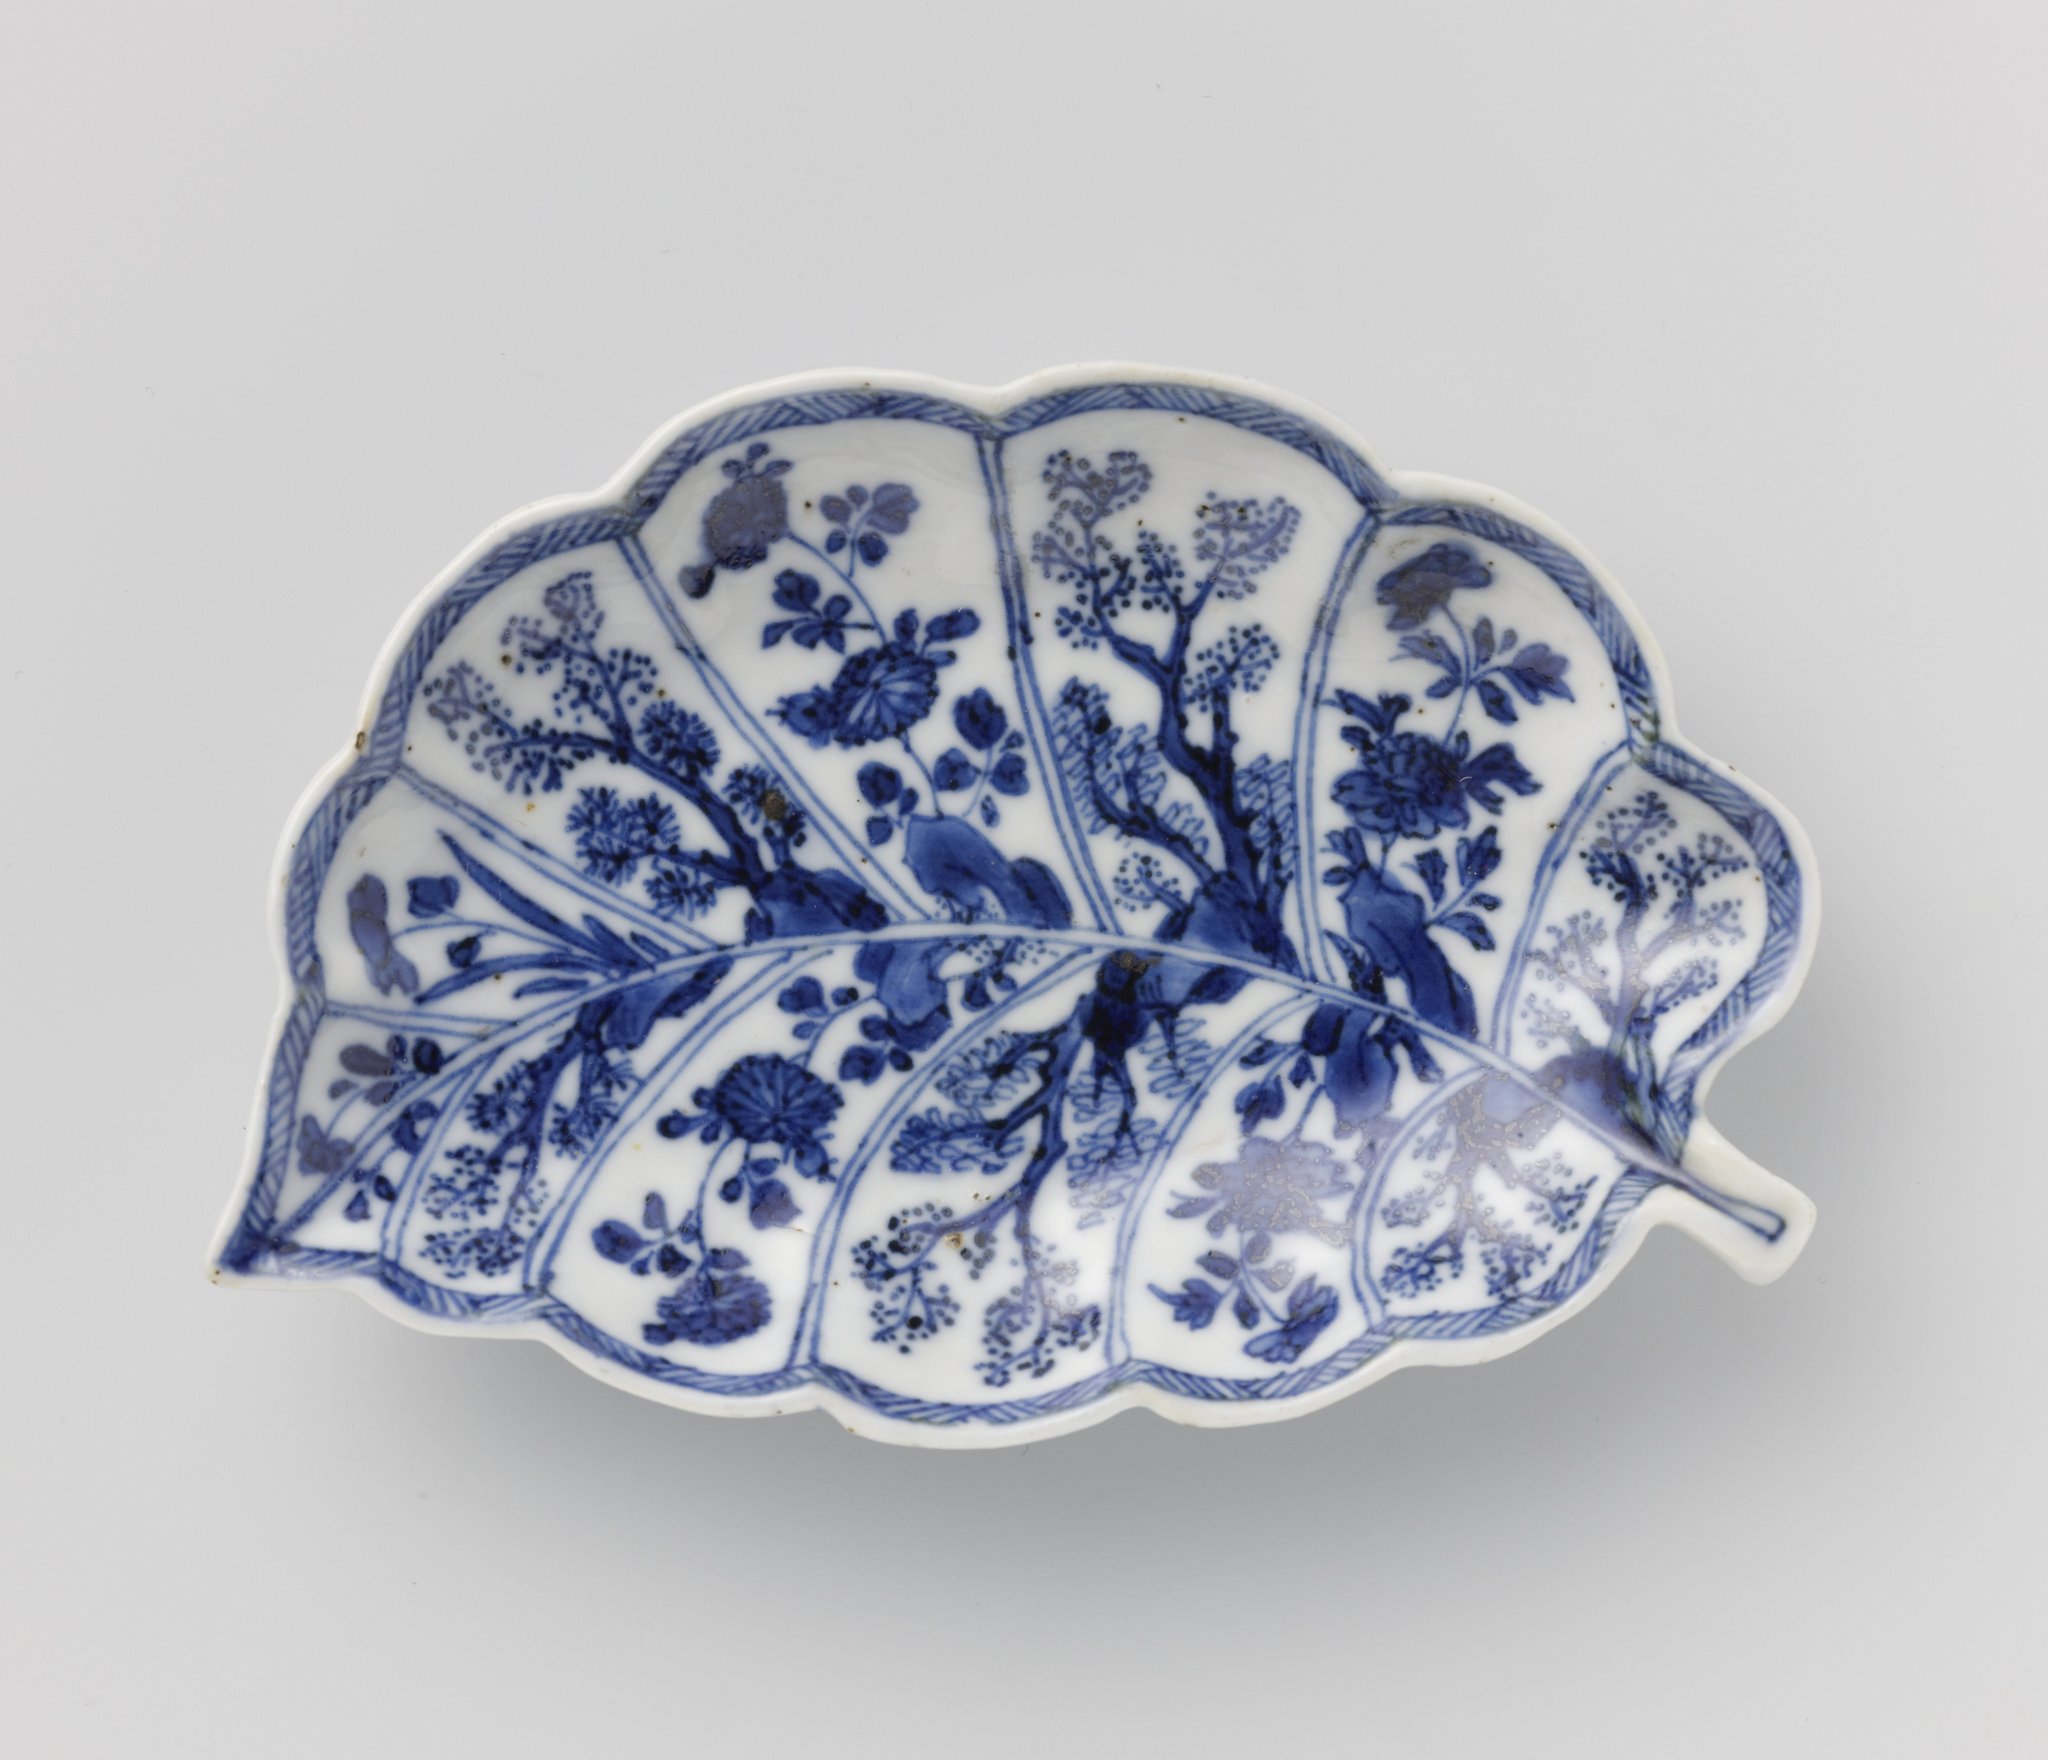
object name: kop en schotel, kop en schotel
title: Cup in the shape of a leaf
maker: Anonymous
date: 1750-1774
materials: cobalt, glaze, paint, porcelain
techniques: firing, forming, turning, vitrification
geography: china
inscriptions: mark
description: Kop van porselein, beschilderd in onderglazuur blauw. De schotel is met vakdecoratie verdeeld door de 'nerven' van het blad, gevuld met verschillende bloeiende planten op een rots. Blauw-wit.